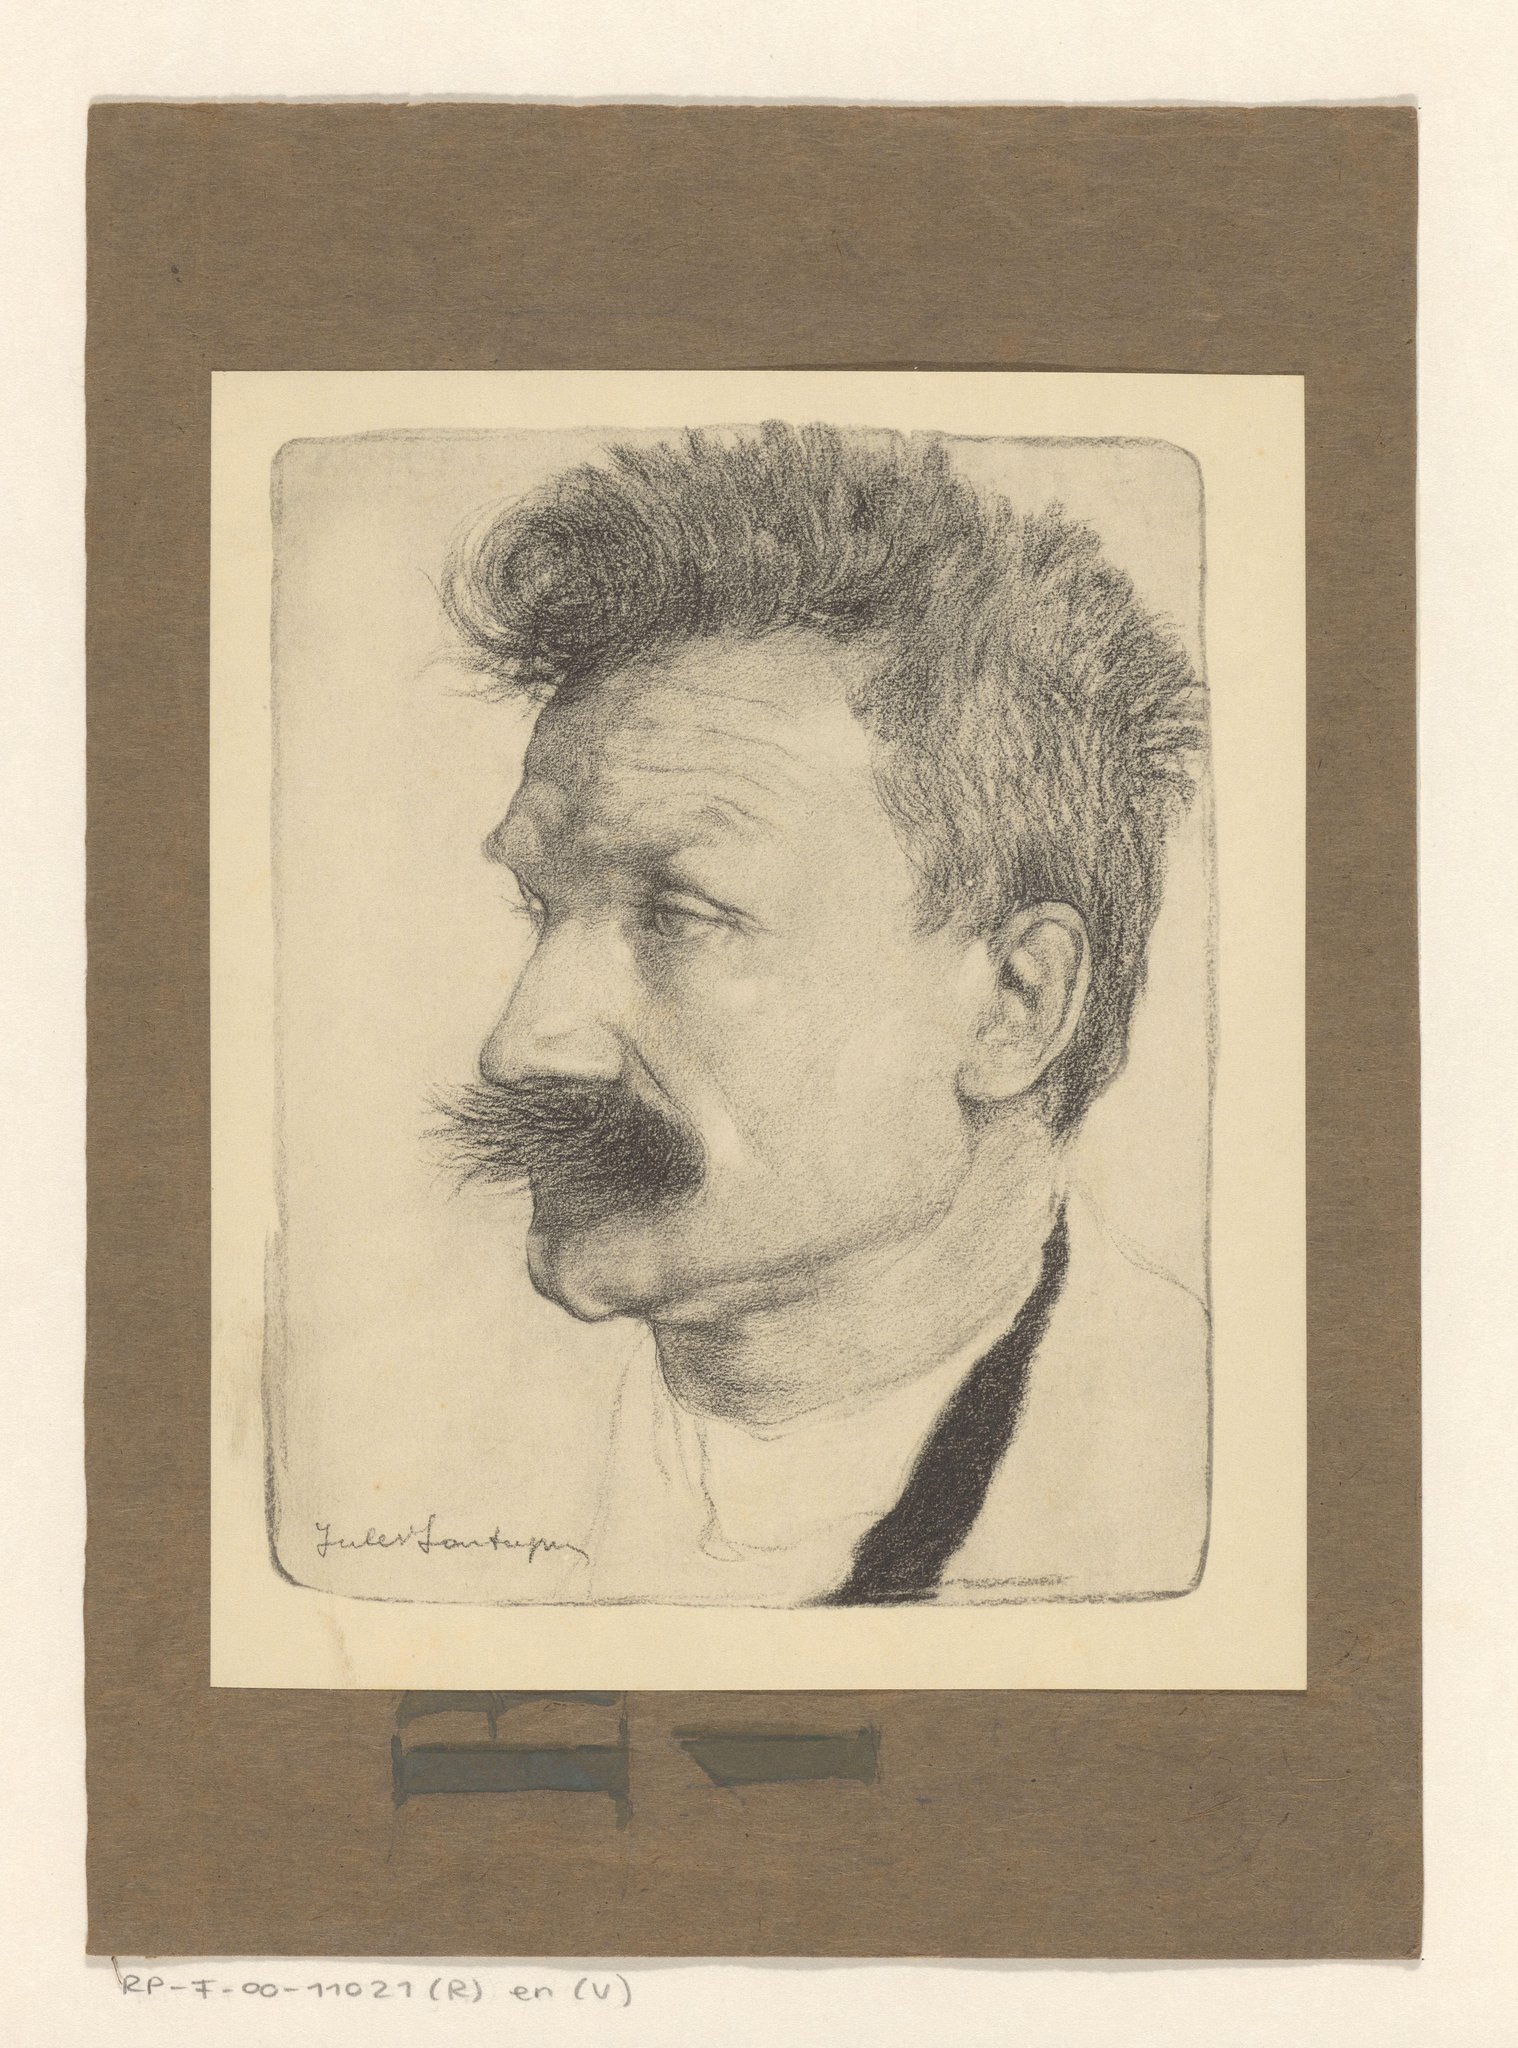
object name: reproduction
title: Reproductie van een getekend portret van Stijn Streuvels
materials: cardboard, paper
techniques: photograph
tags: stijn streuvels, portrait of a writer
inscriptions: collector's mark: Lugt 2228a